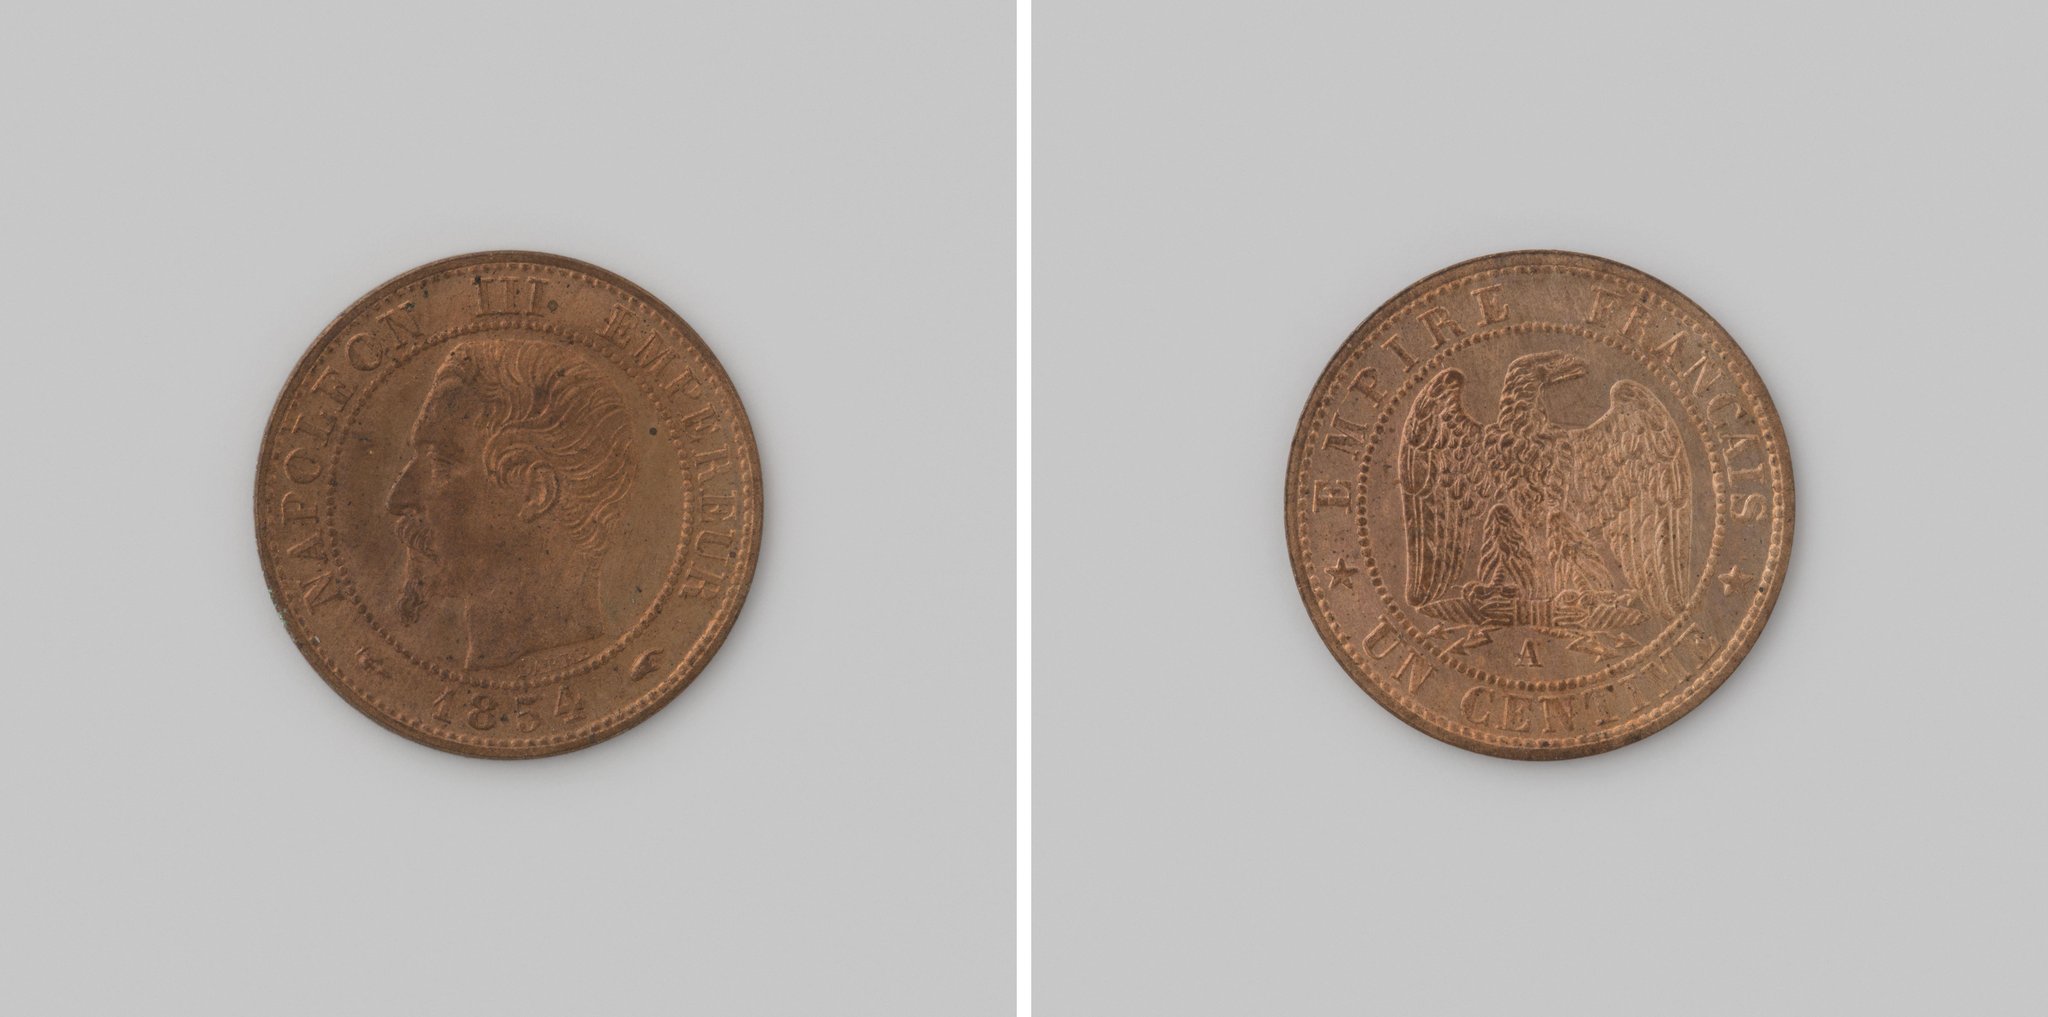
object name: centime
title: Keizerrijk Frankrijk, Napoleon III, centime,1854 A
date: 1854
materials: bronze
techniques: striking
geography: paris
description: Bronzen munt. Voorzijde: hoofd van de keizer naar links. Jaartal onderaan. Keerzijde: op bundel, waaruit bliksemschichten, staande, naar rechts kijkende adelaar met gespreide vleugels, waaronder de letter A [=Parijs]. Waarde-aanduiding onderaan in omschrift. Gladde rand.